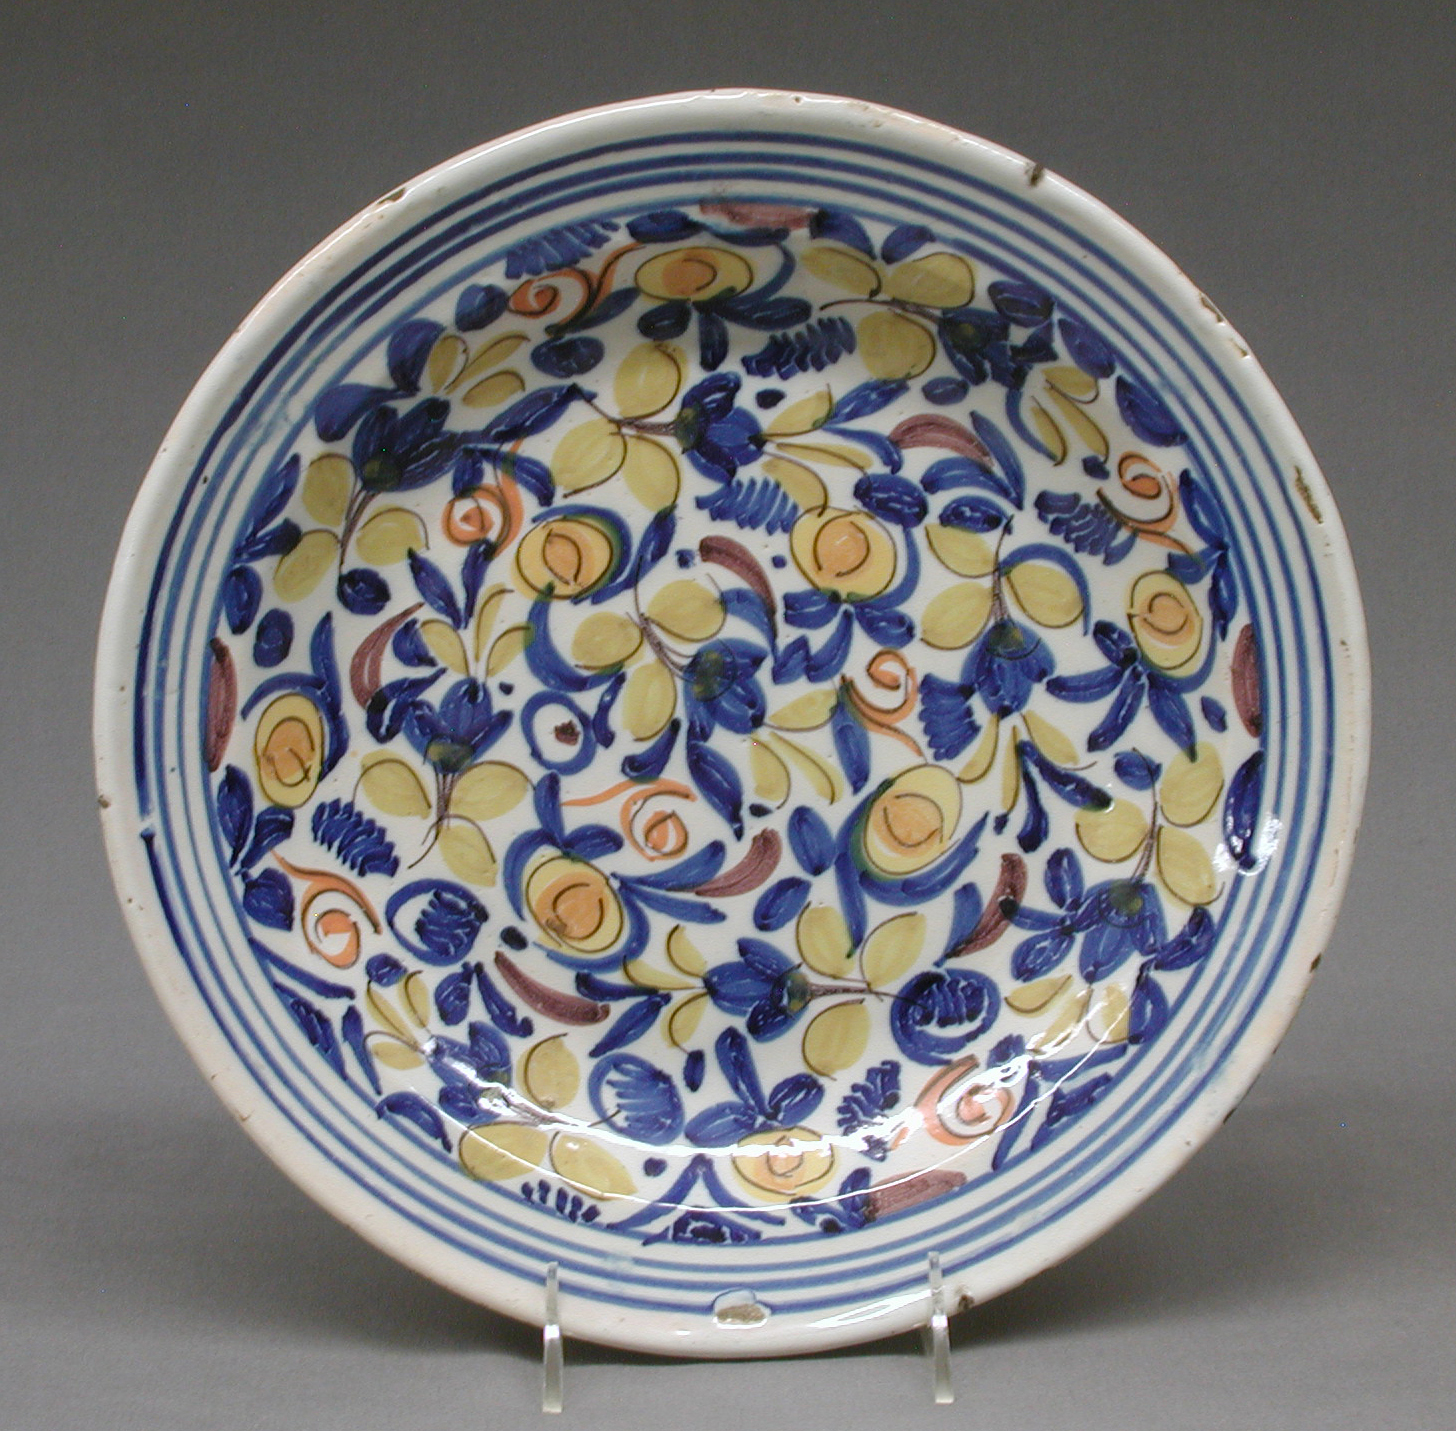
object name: dish or plaque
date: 1801-1900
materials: earthenware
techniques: glazing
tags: flowers